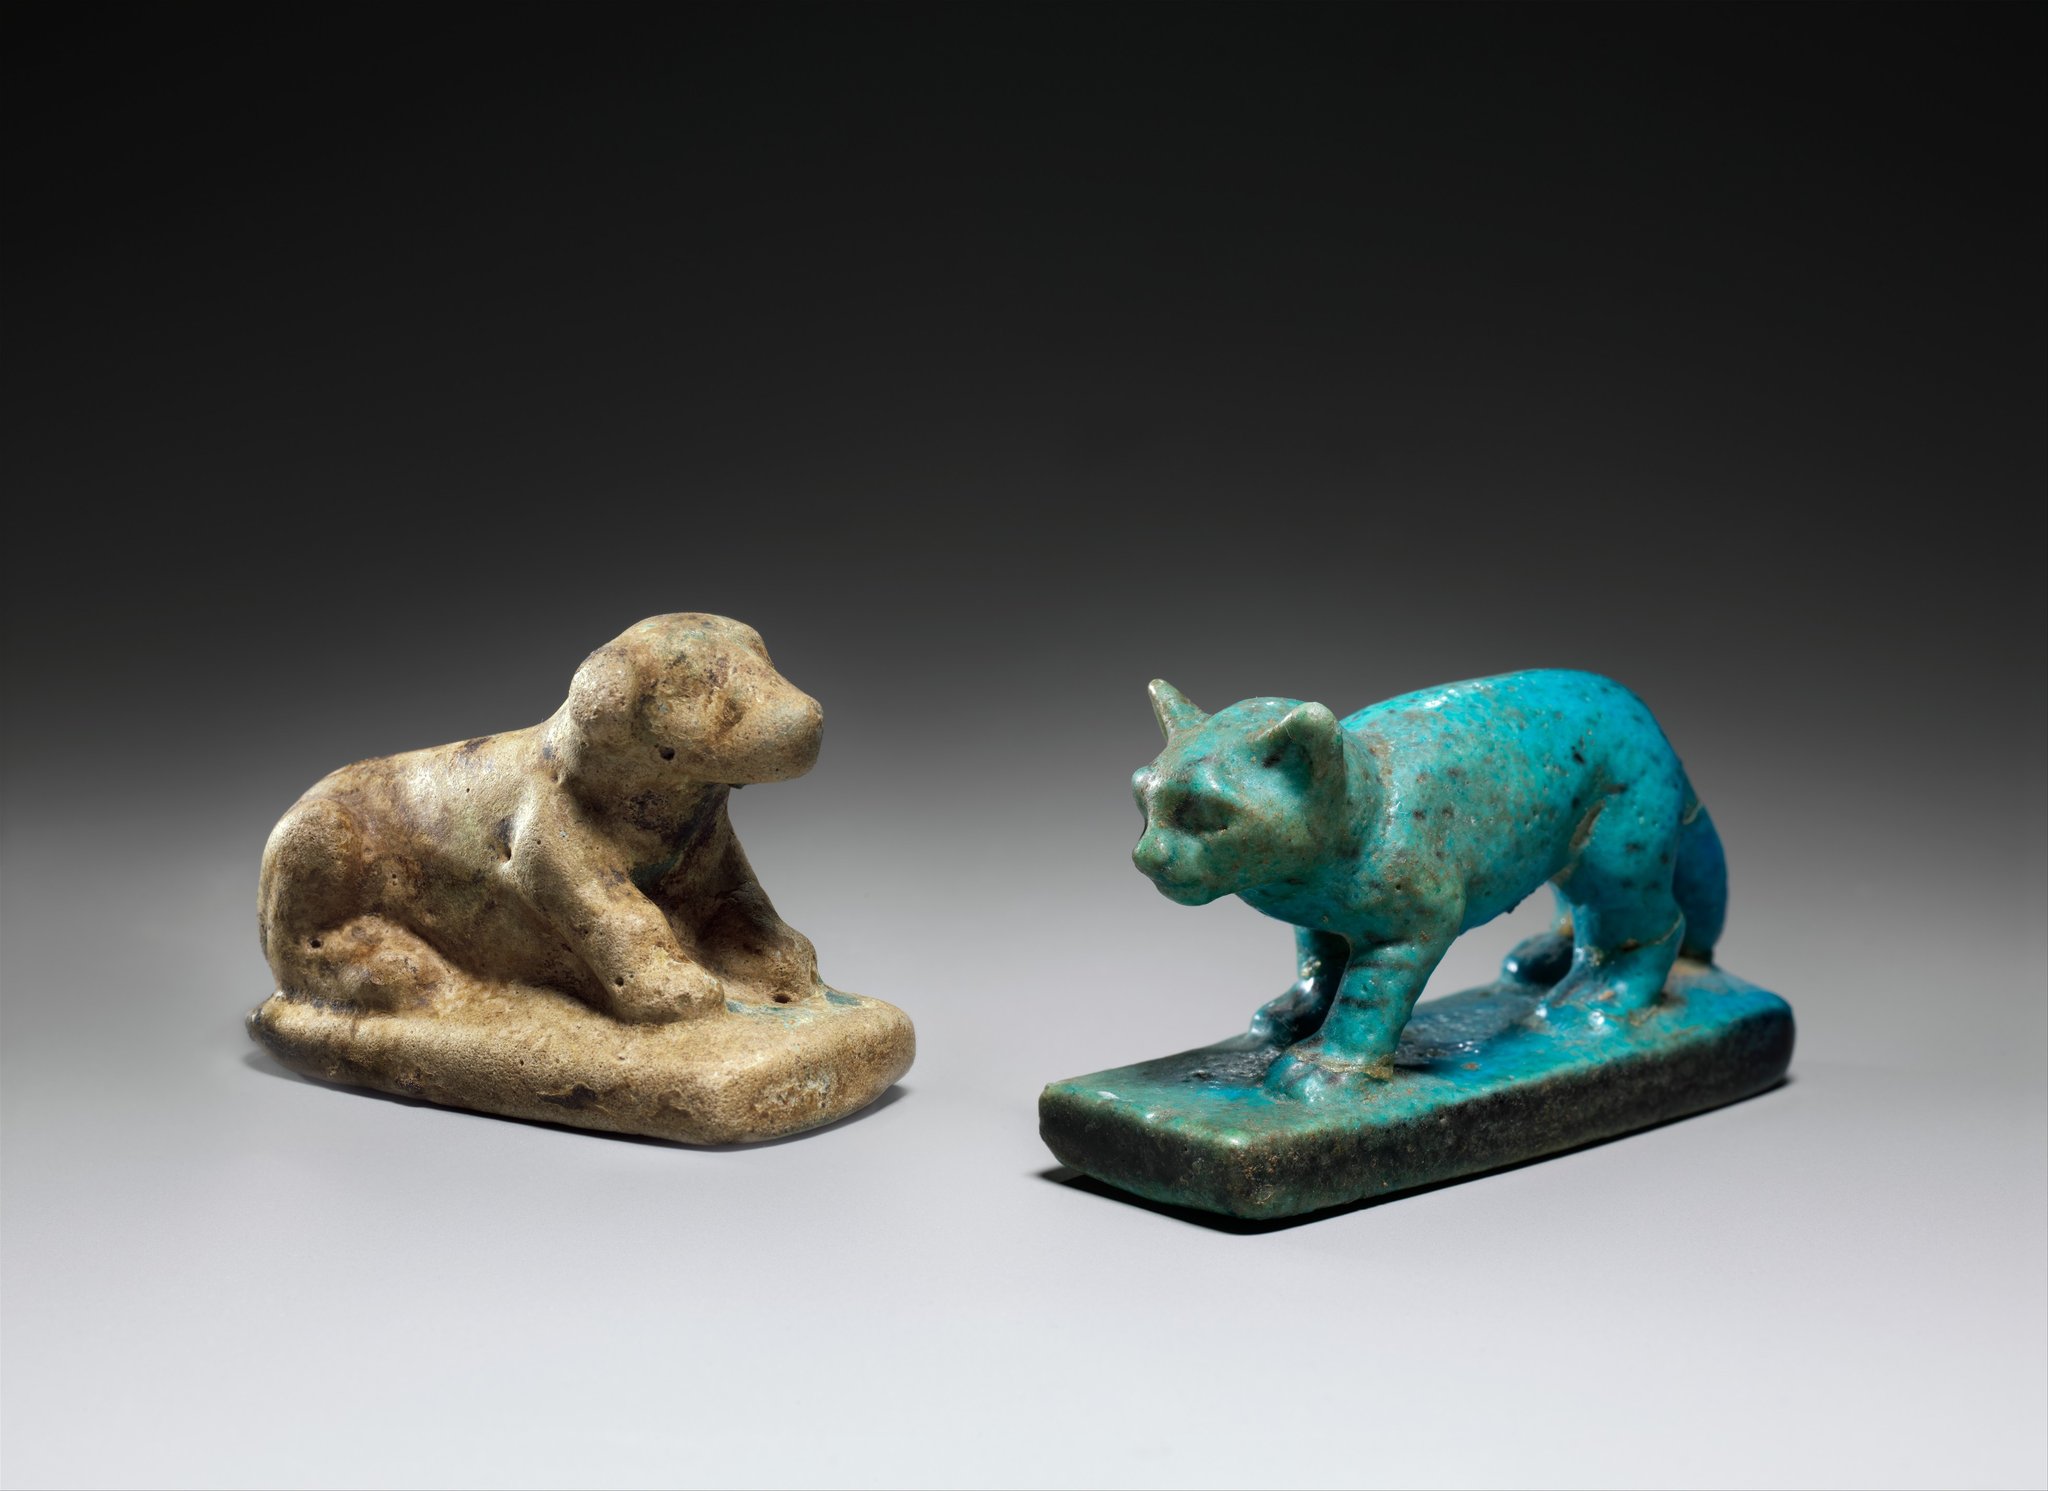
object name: dog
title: Figurine of a Dog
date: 1961-1917 BCE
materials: faience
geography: egypt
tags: dogs